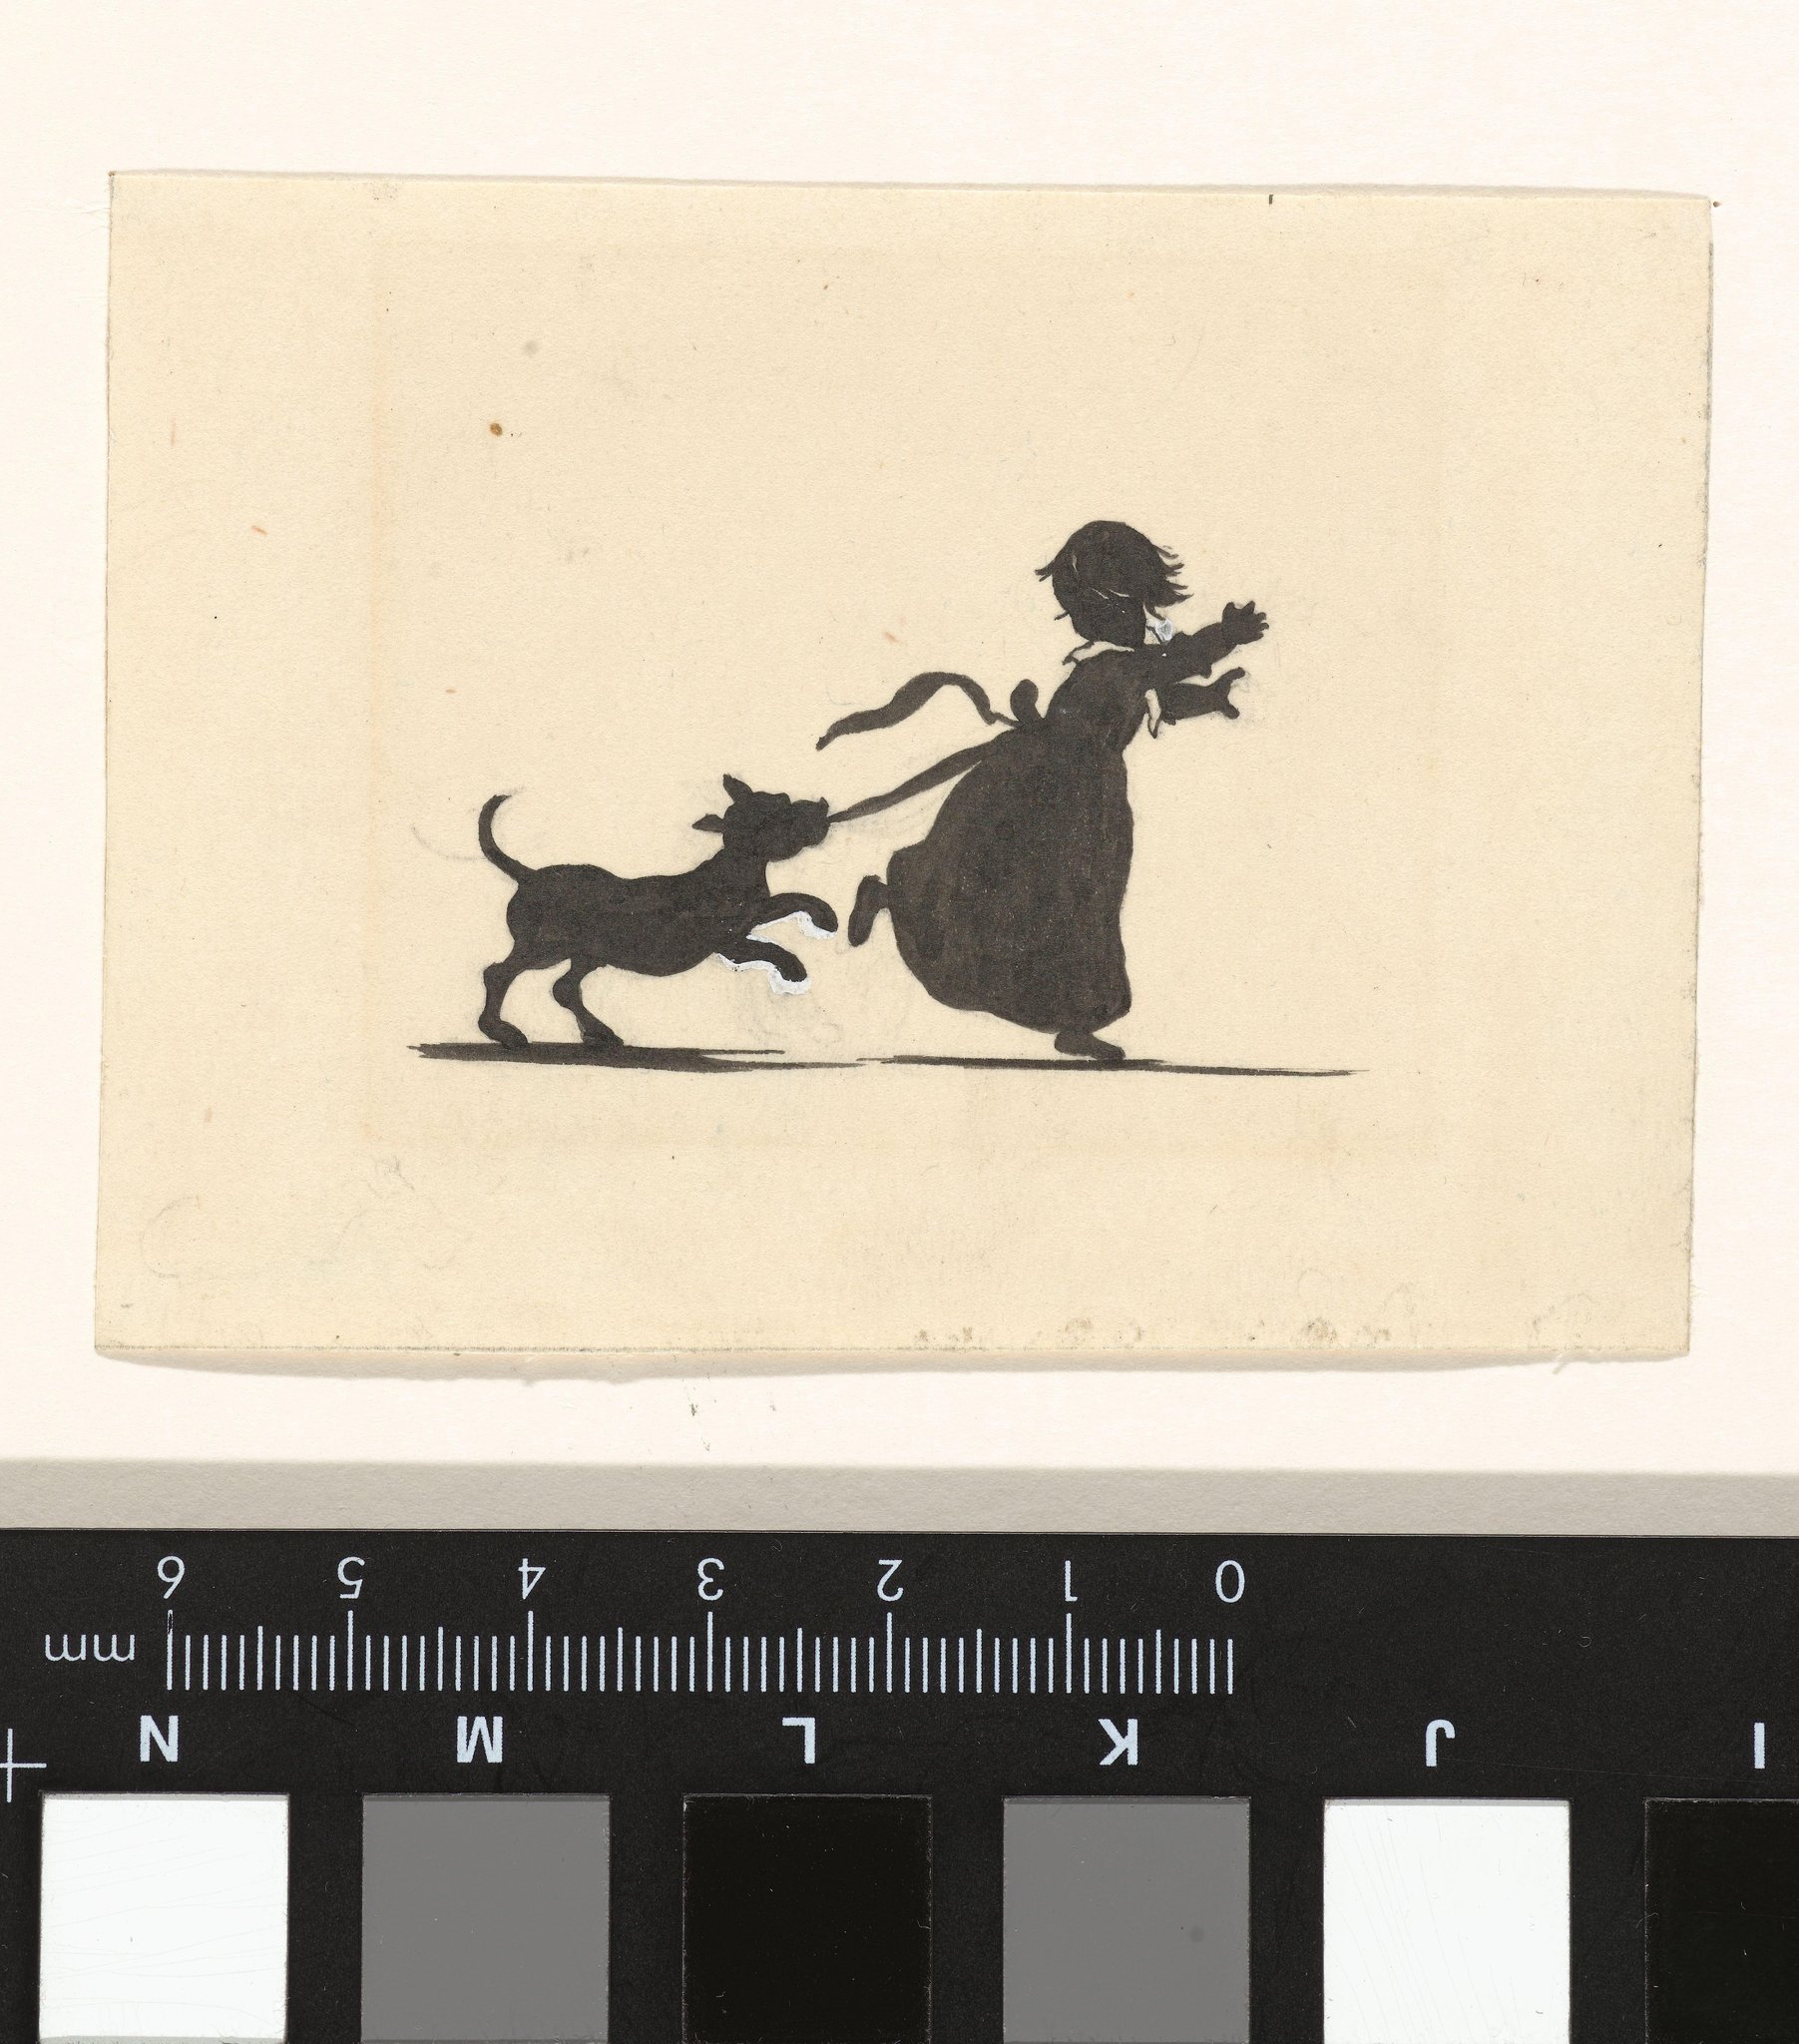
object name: design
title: Ontwerp voor illustratie voor In Holland staat een huis: silhouet van de hond die achter het meisje aanzit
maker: nelly bodenheim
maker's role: designer, draughtsman, print maker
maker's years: 1874-1951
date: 1884-1917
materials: paint, paper, pencil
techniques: brush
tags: 83(van looy, in holland staat een huis)